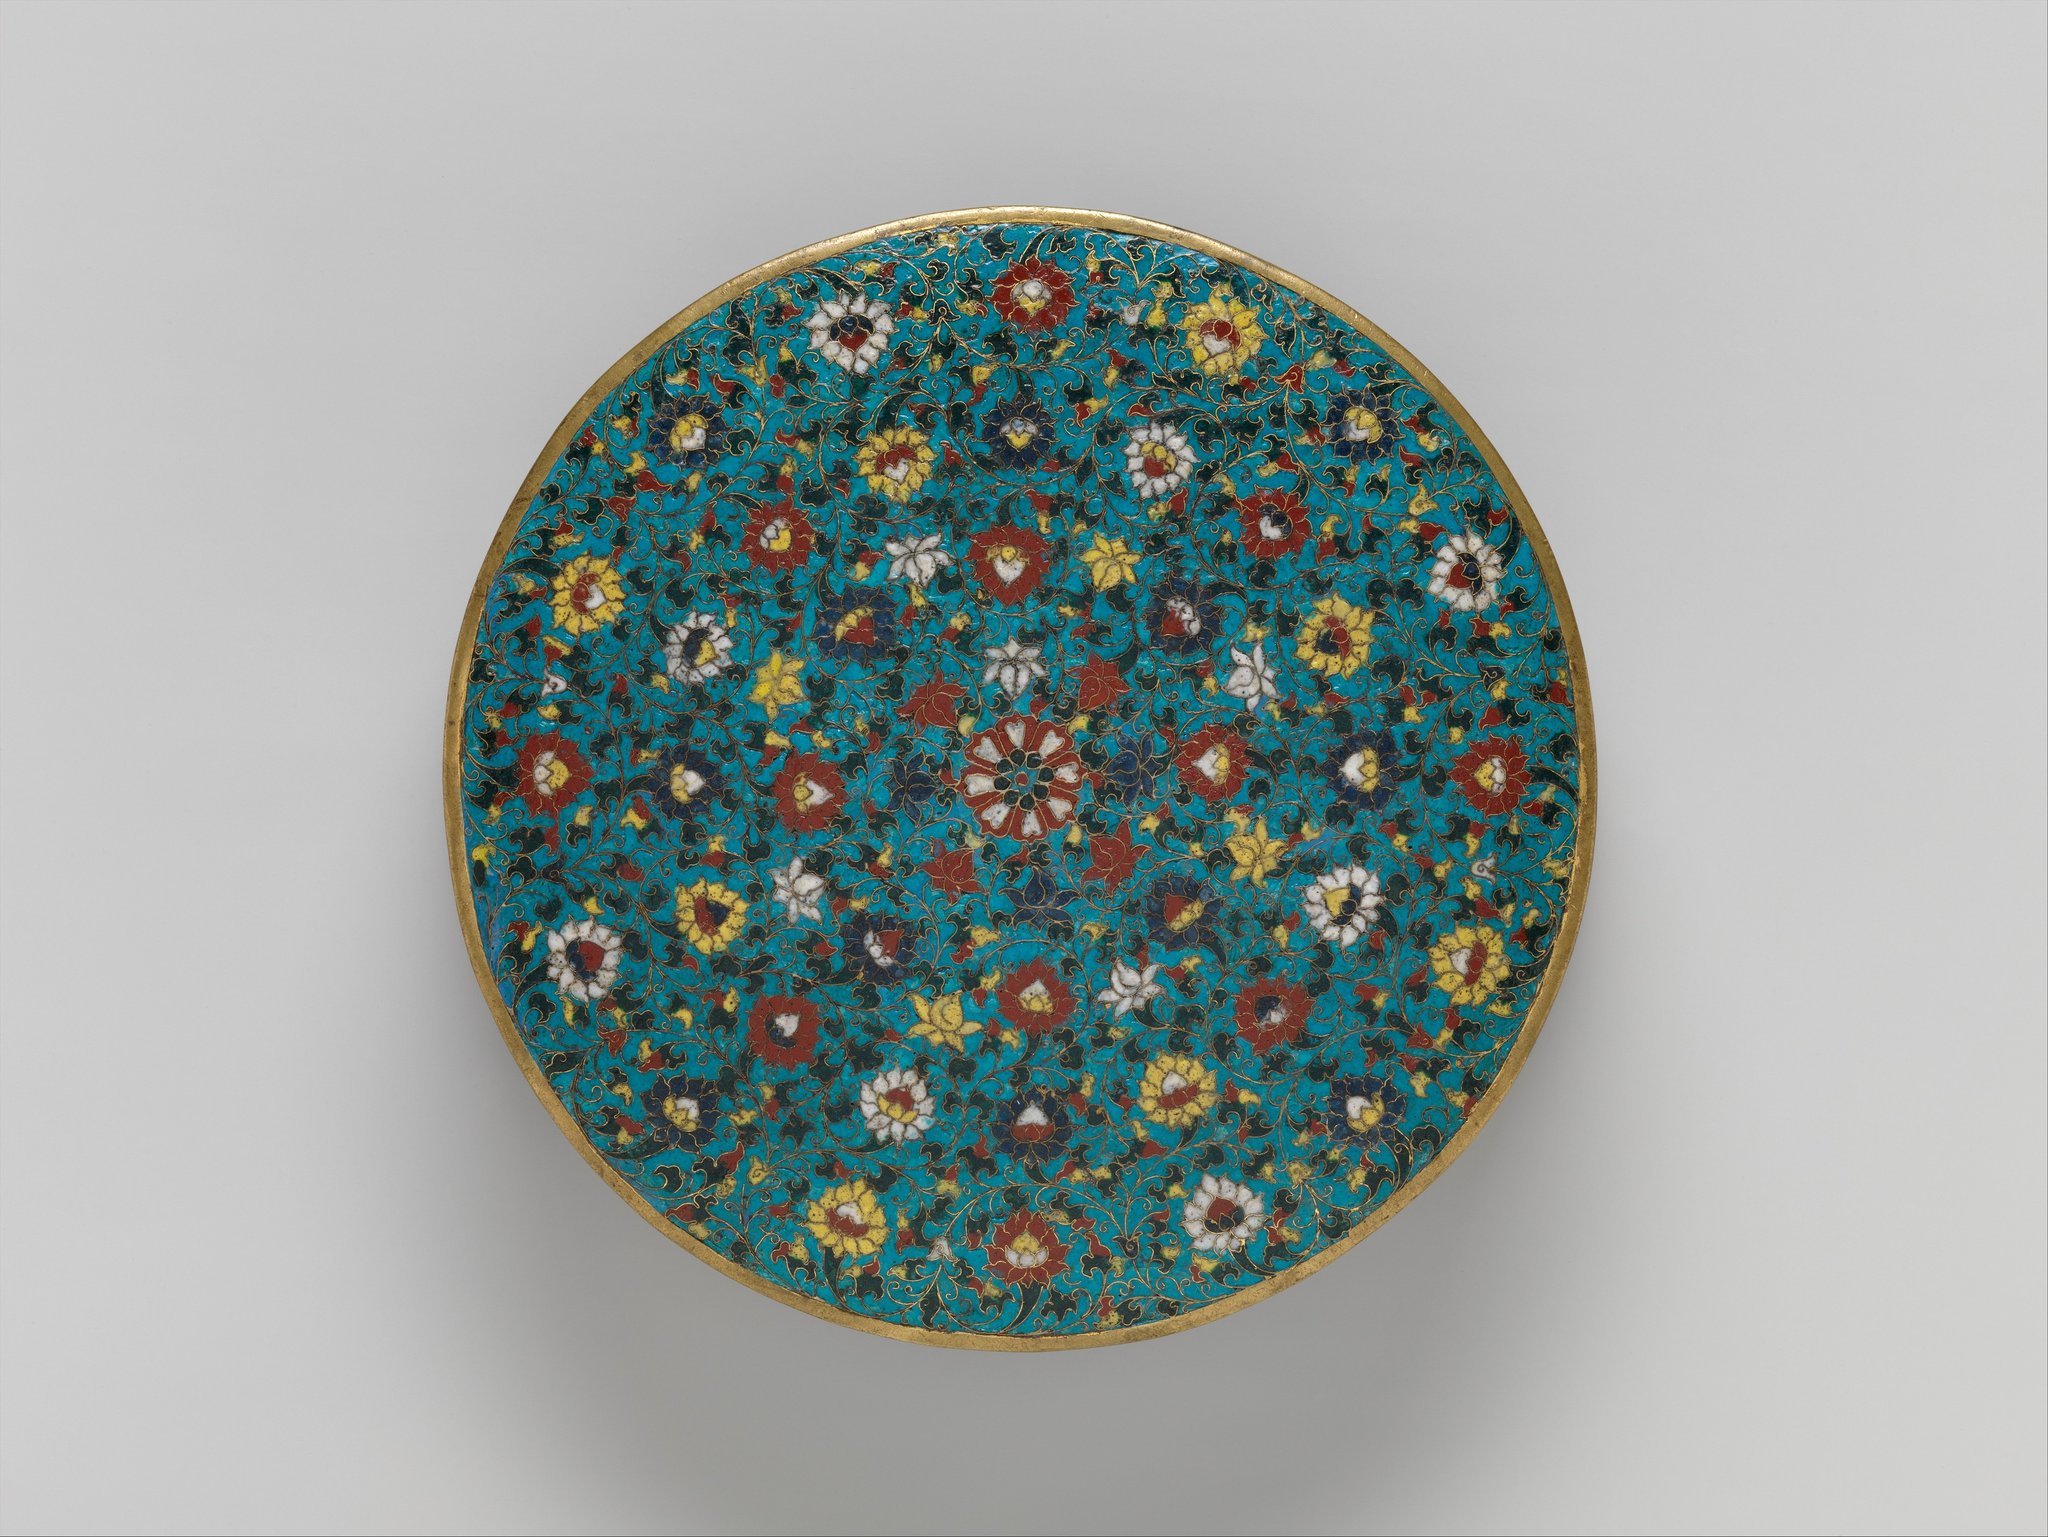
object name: base for a mandala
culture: chinese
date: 1401-1450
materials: enamel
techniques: enamel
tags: flowers